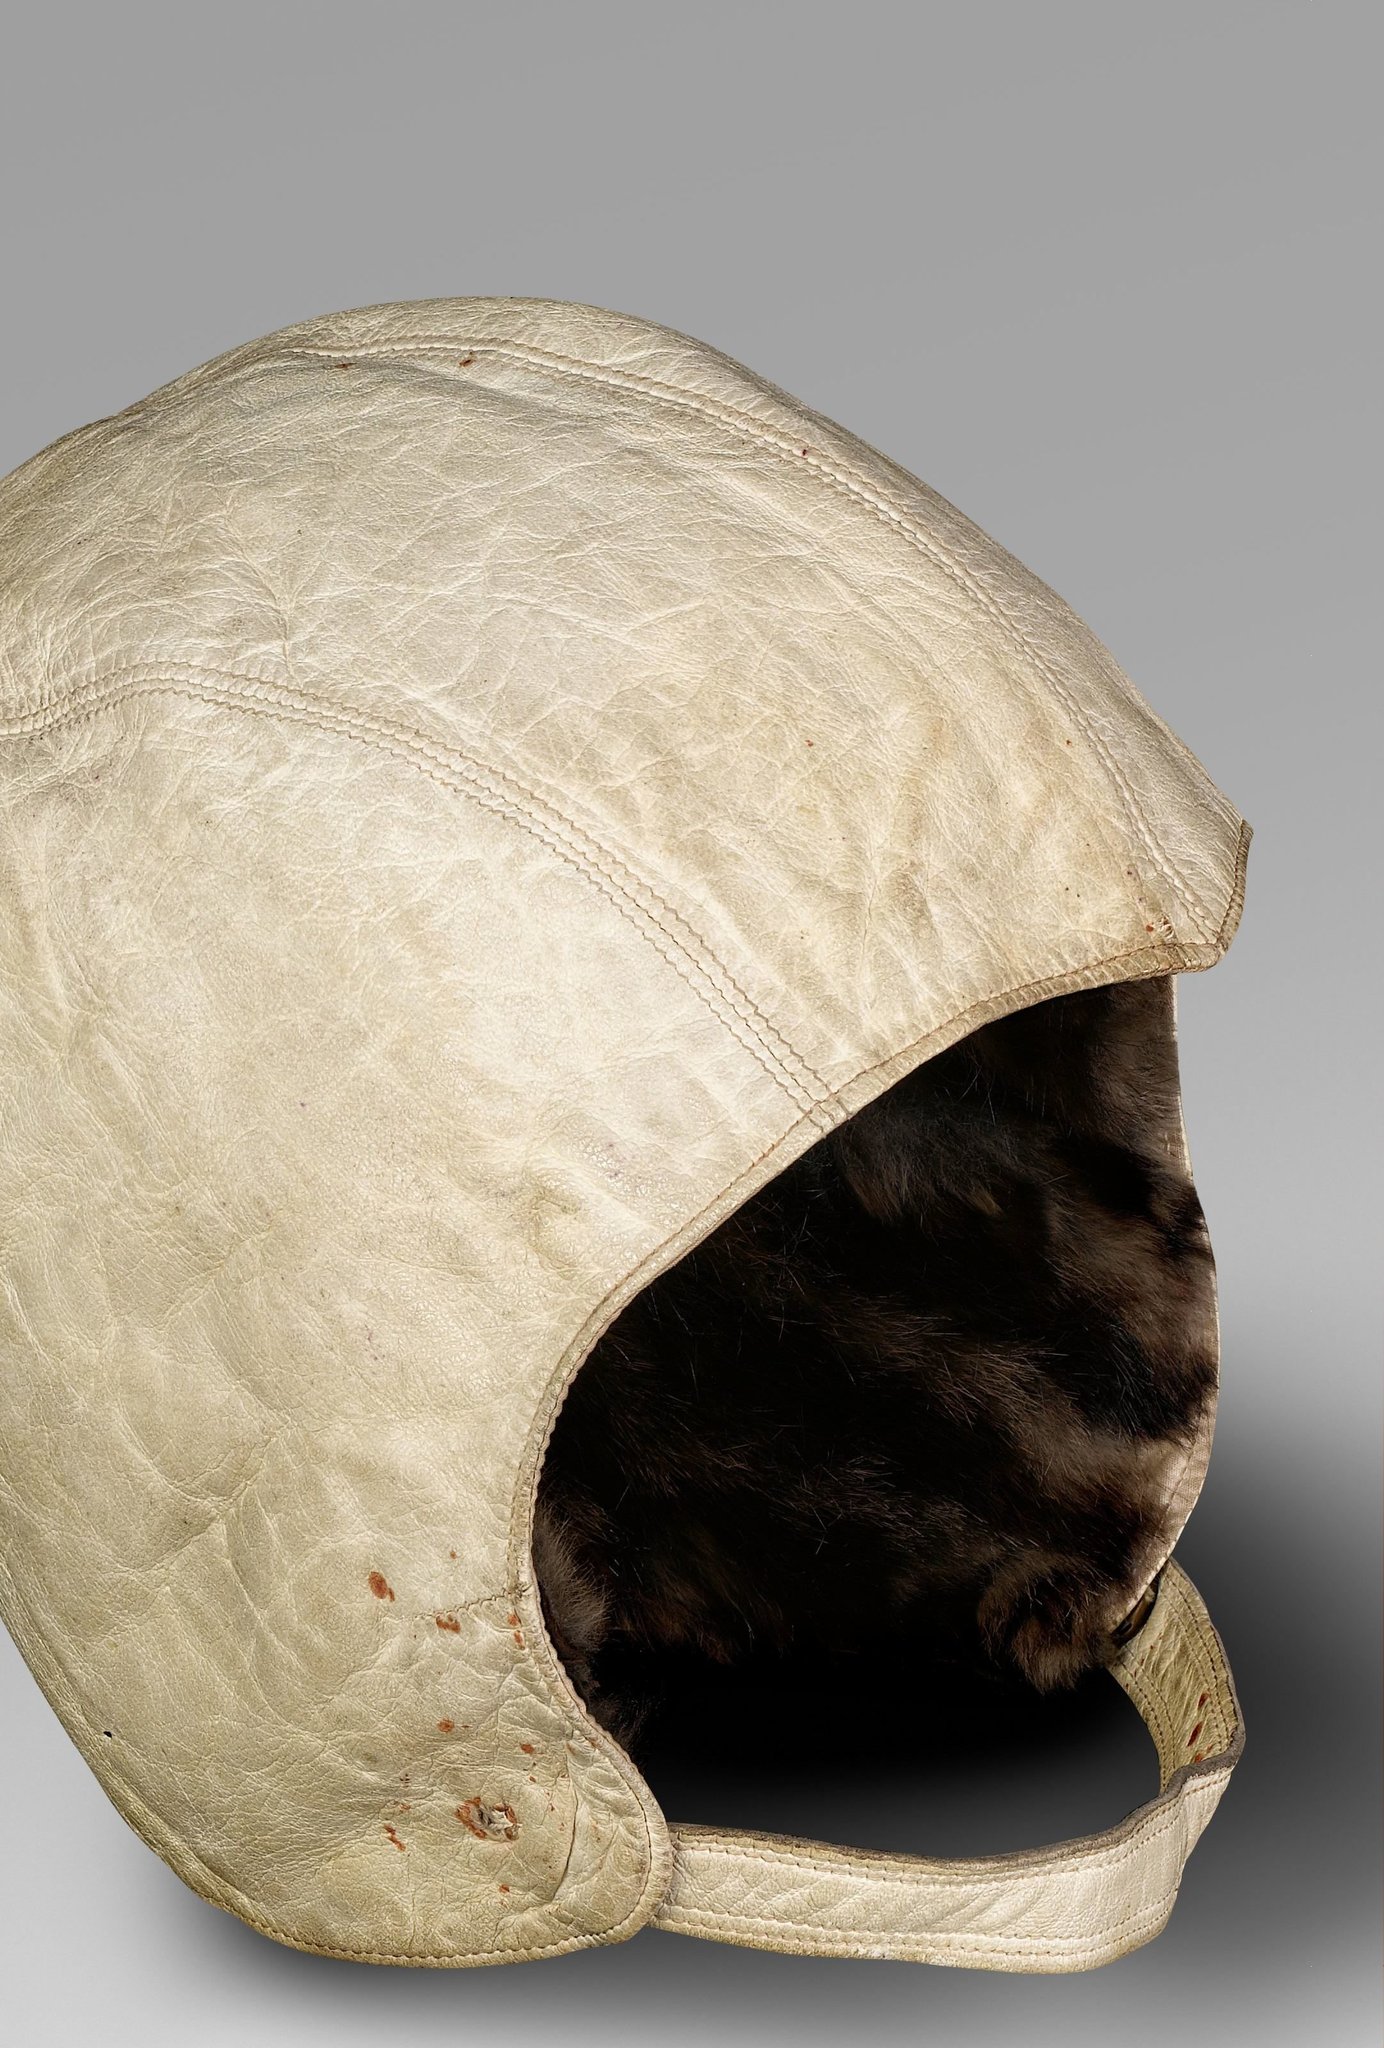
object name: cap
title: Motormuts van wit leer met kinband, voorzien van oorwarmers van bont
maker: Anonymous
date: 1900-1925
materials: fur, leather, linen, metal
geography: netherlands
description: Motormuts van wit leer met kinband, voorzien van oorwarmers van bont (ocelot?). Vliegermodel met kinband met drukknoopsluiting en linnen voering.